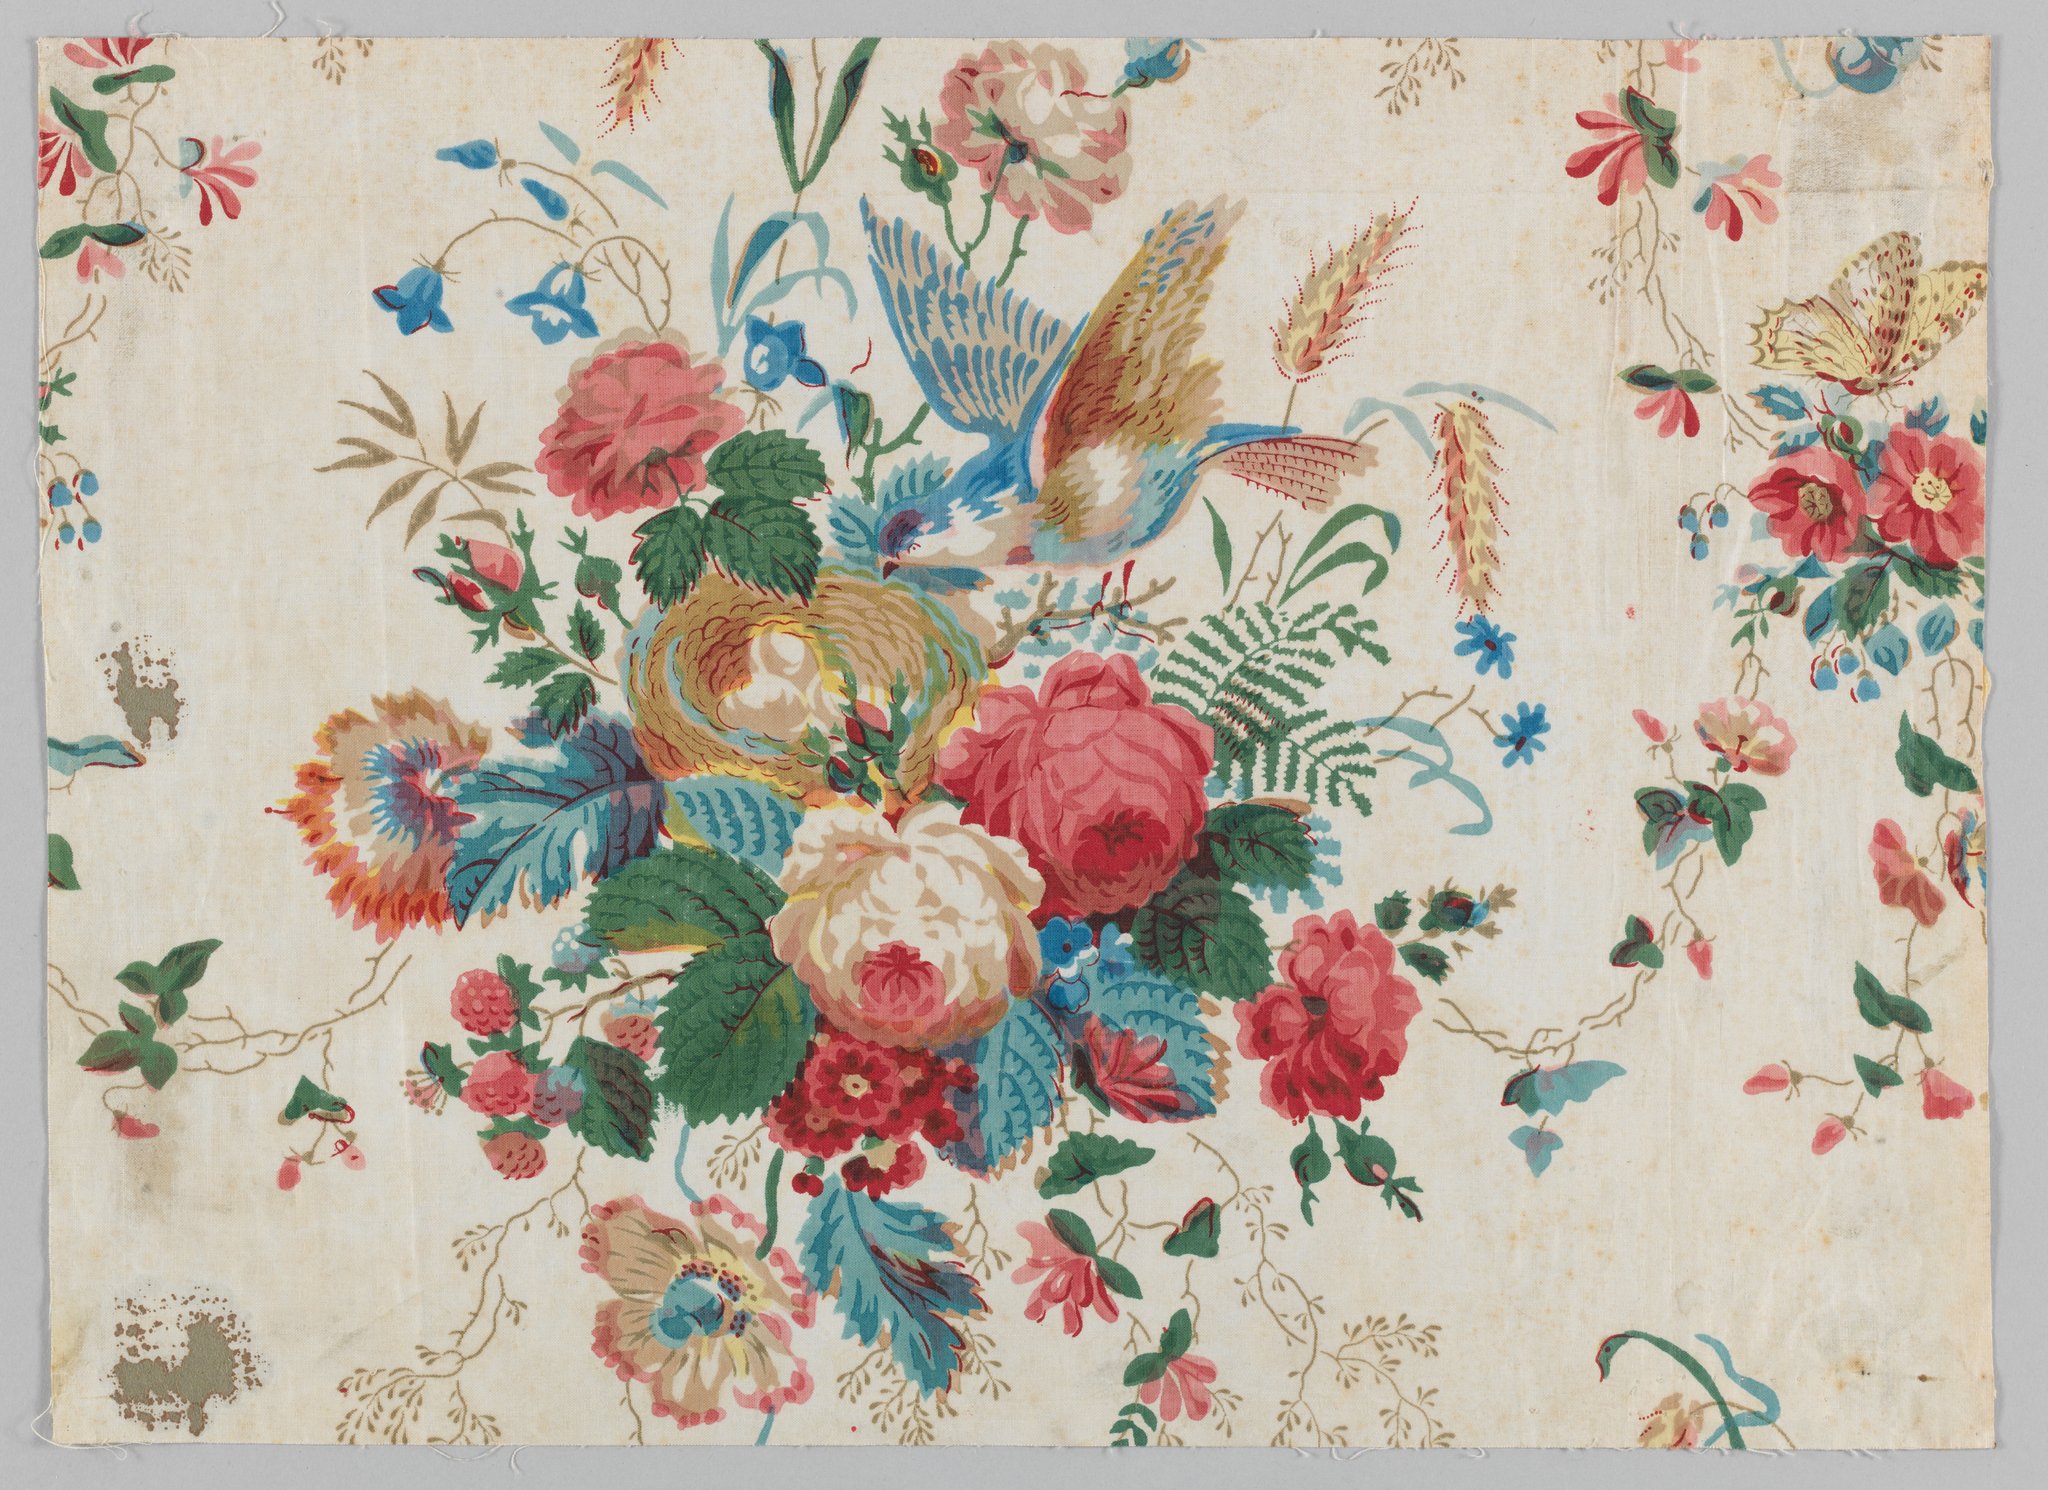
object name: piece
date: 1801-1900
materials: cotton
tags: birds,flowers